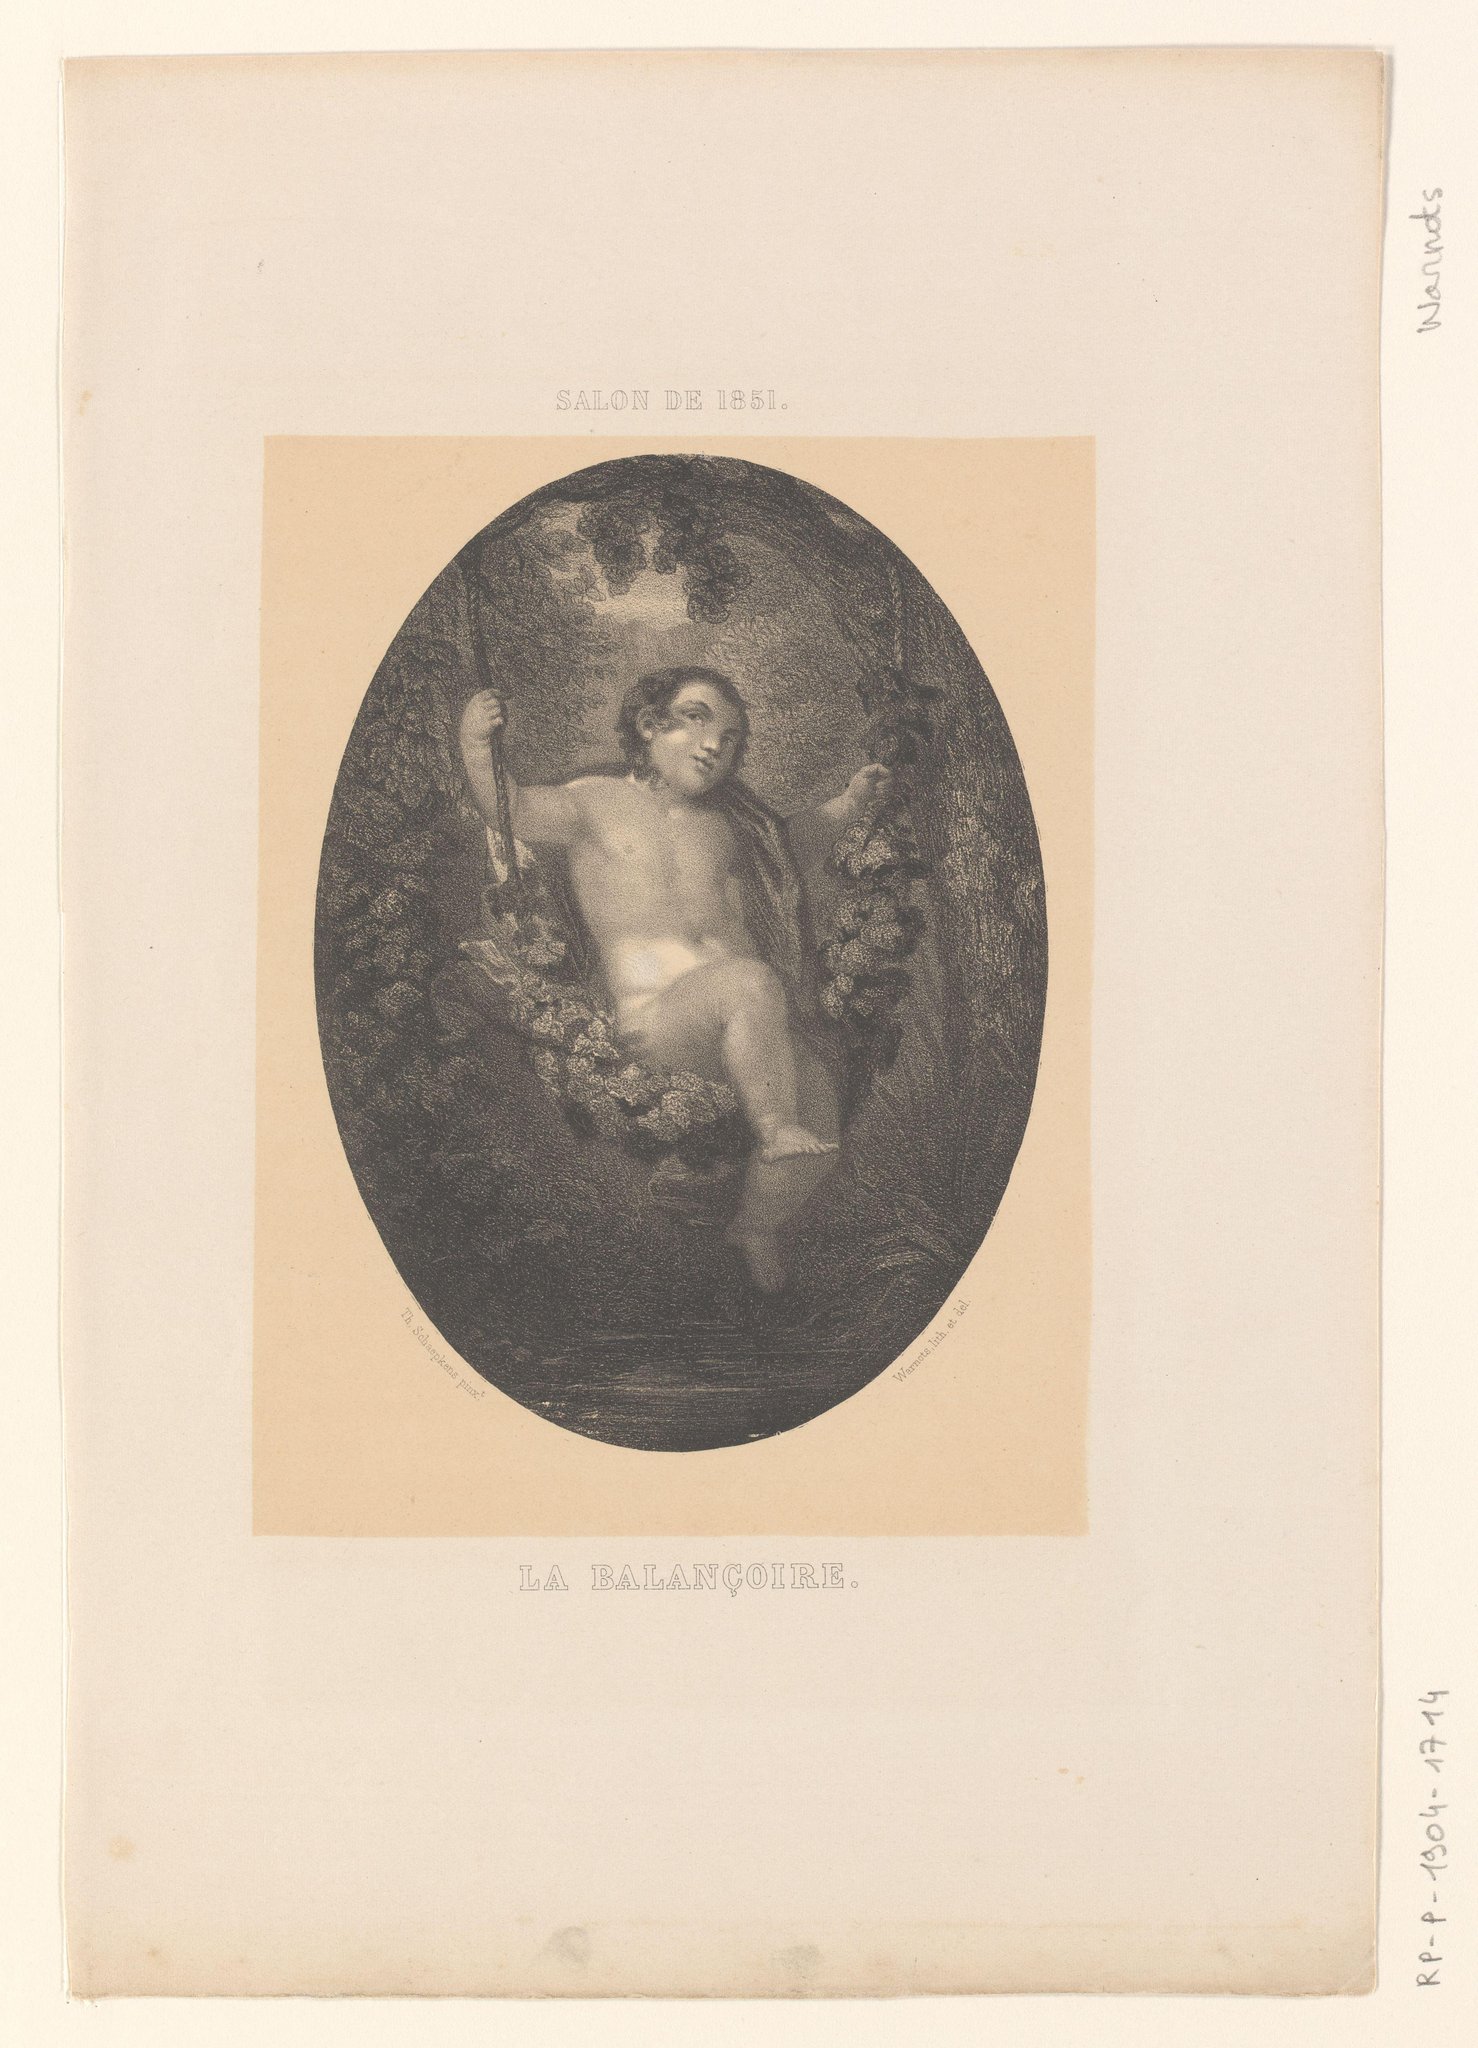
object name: print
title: La balancoire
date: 1851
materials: paper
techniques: tone lithography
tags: child, swing, cupids: 'amores', 'amoretti', 'putti'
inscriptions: date